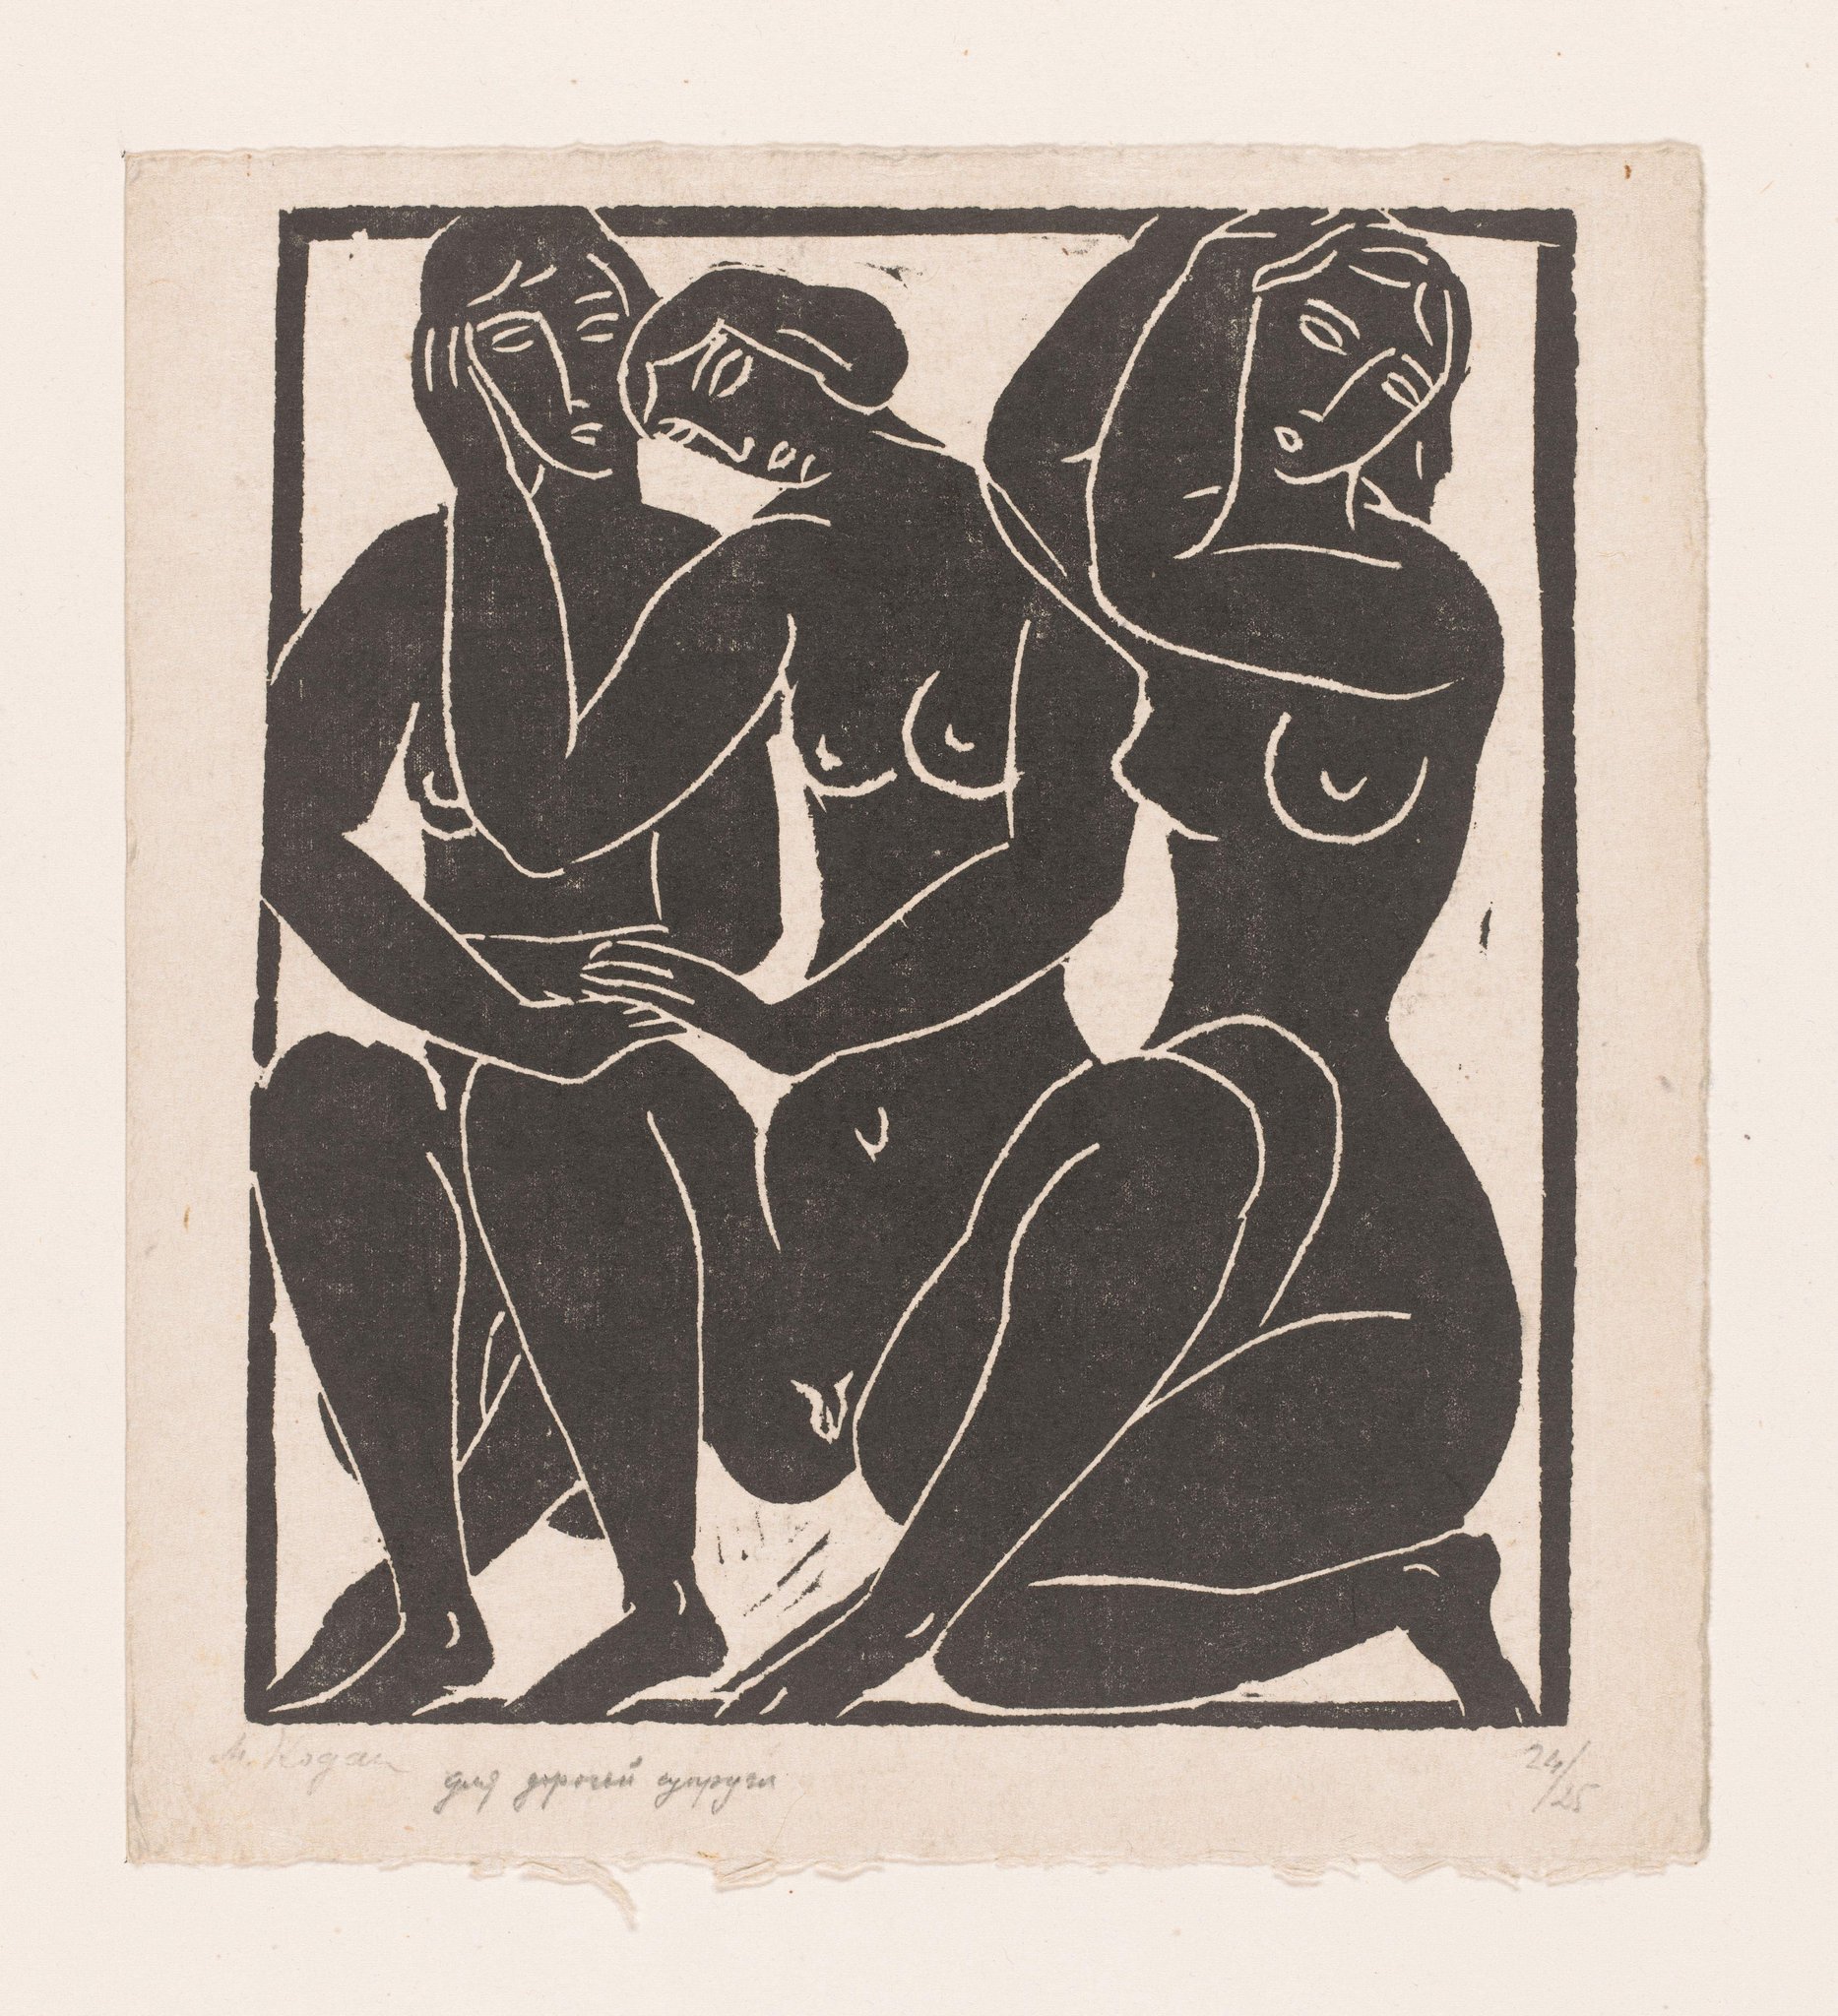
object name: print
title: Drie zittende naakte vrouwen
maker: moissej kogan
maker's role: print maker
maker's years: 1879-1943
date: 1889-1943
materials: paper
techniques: linocut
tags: sitting figure - aa - female human figure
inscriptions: collector's mark: Lugt 2228